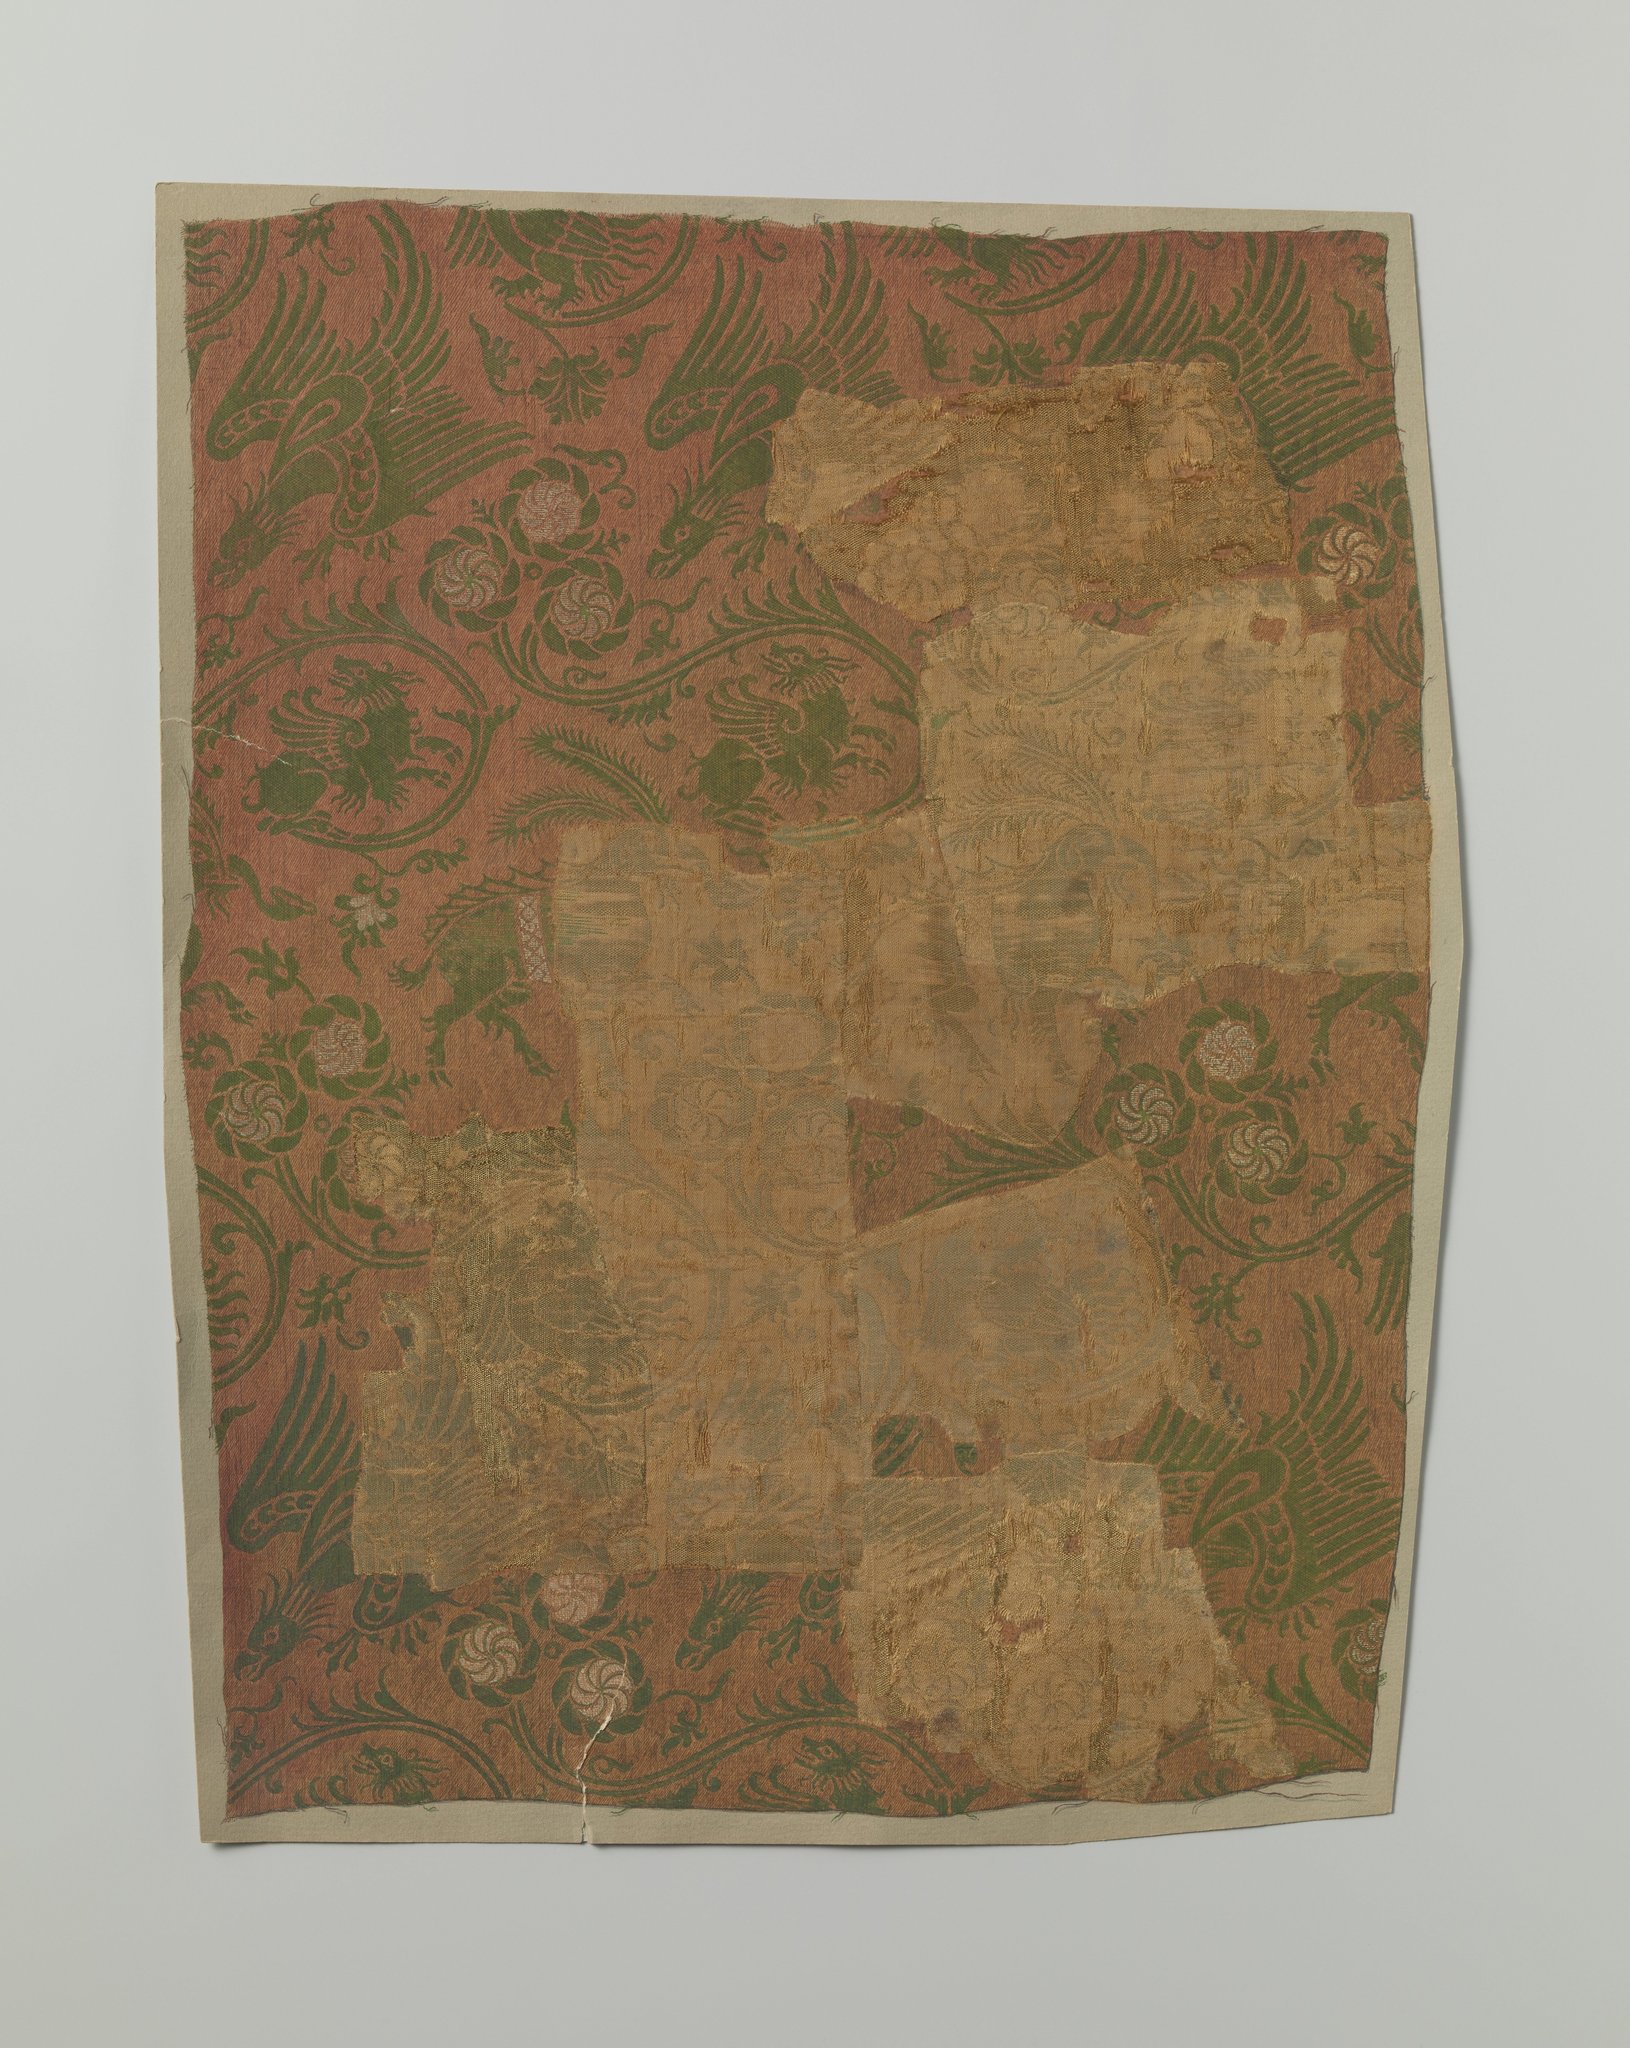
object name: fragment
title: Fragment zijdeweefsel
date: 1907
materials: silk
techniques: samite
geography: italy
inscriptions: signature: ‘Durch Malerei ergänzt von Professor Paul Schulze Crefeld 1907’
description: Fragment van 7 opgeplakte stukken zijde, rondom bijgetekend. Patroon van bloem- en bladranken waartussen dieren: vliegende vogel, tapir met koeienhoeven, rugvin en pauwenveren op de kop en een achteromziend gevleugeld viervoetig dier.